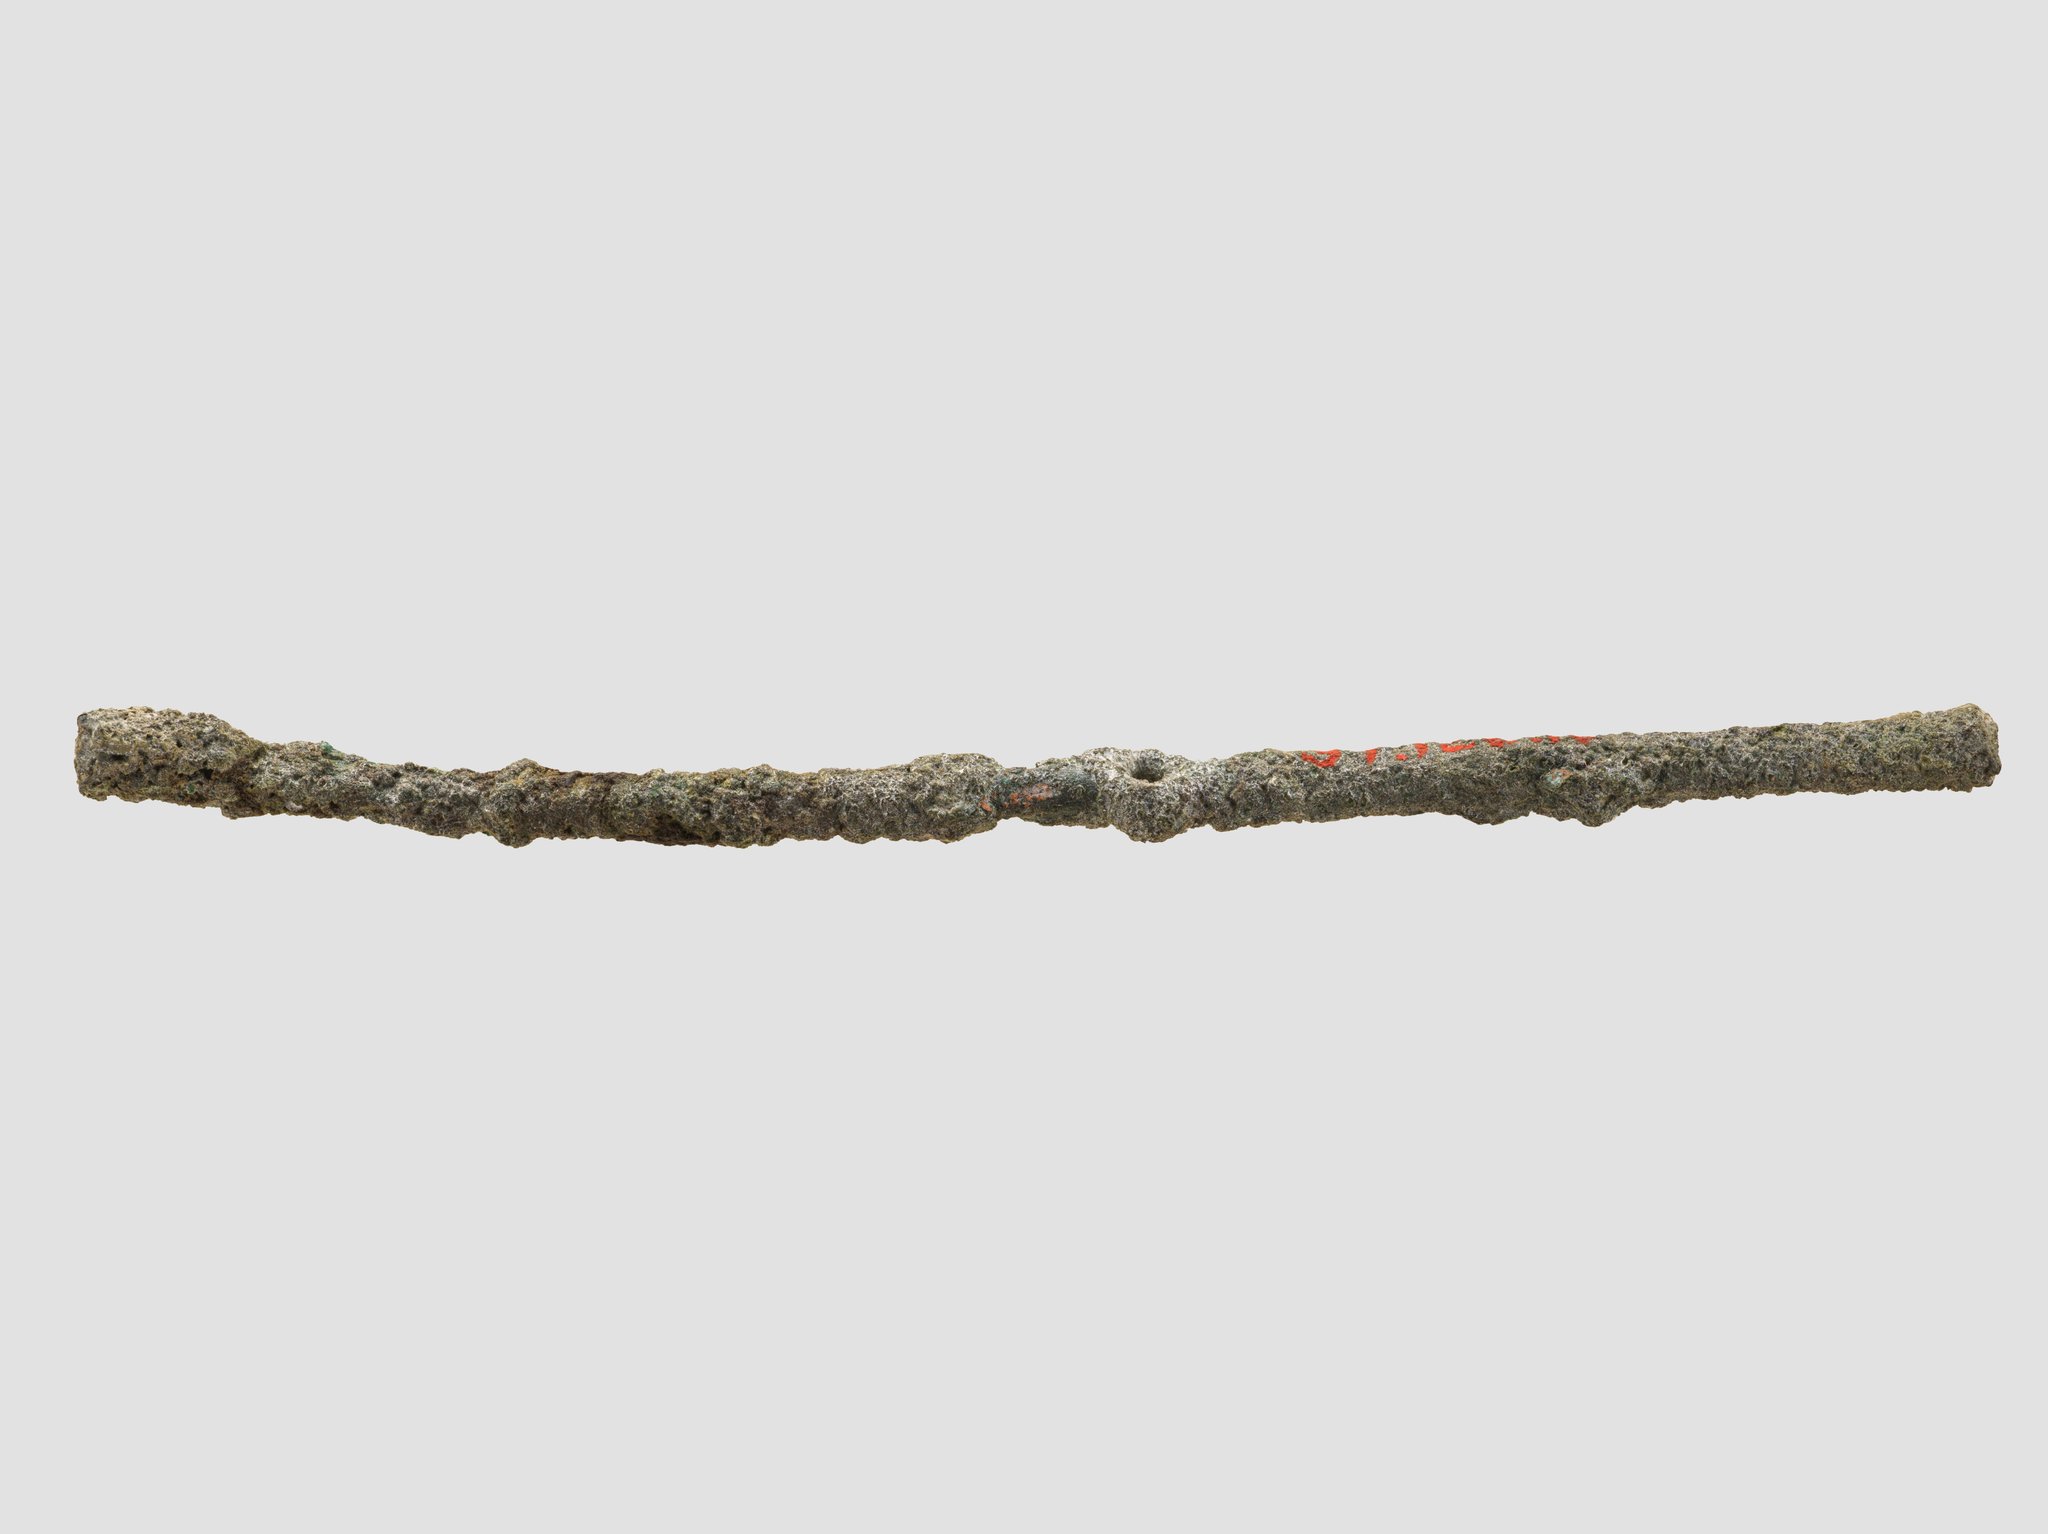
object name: pin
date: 1780-1580 BCE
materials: bronze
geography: levant